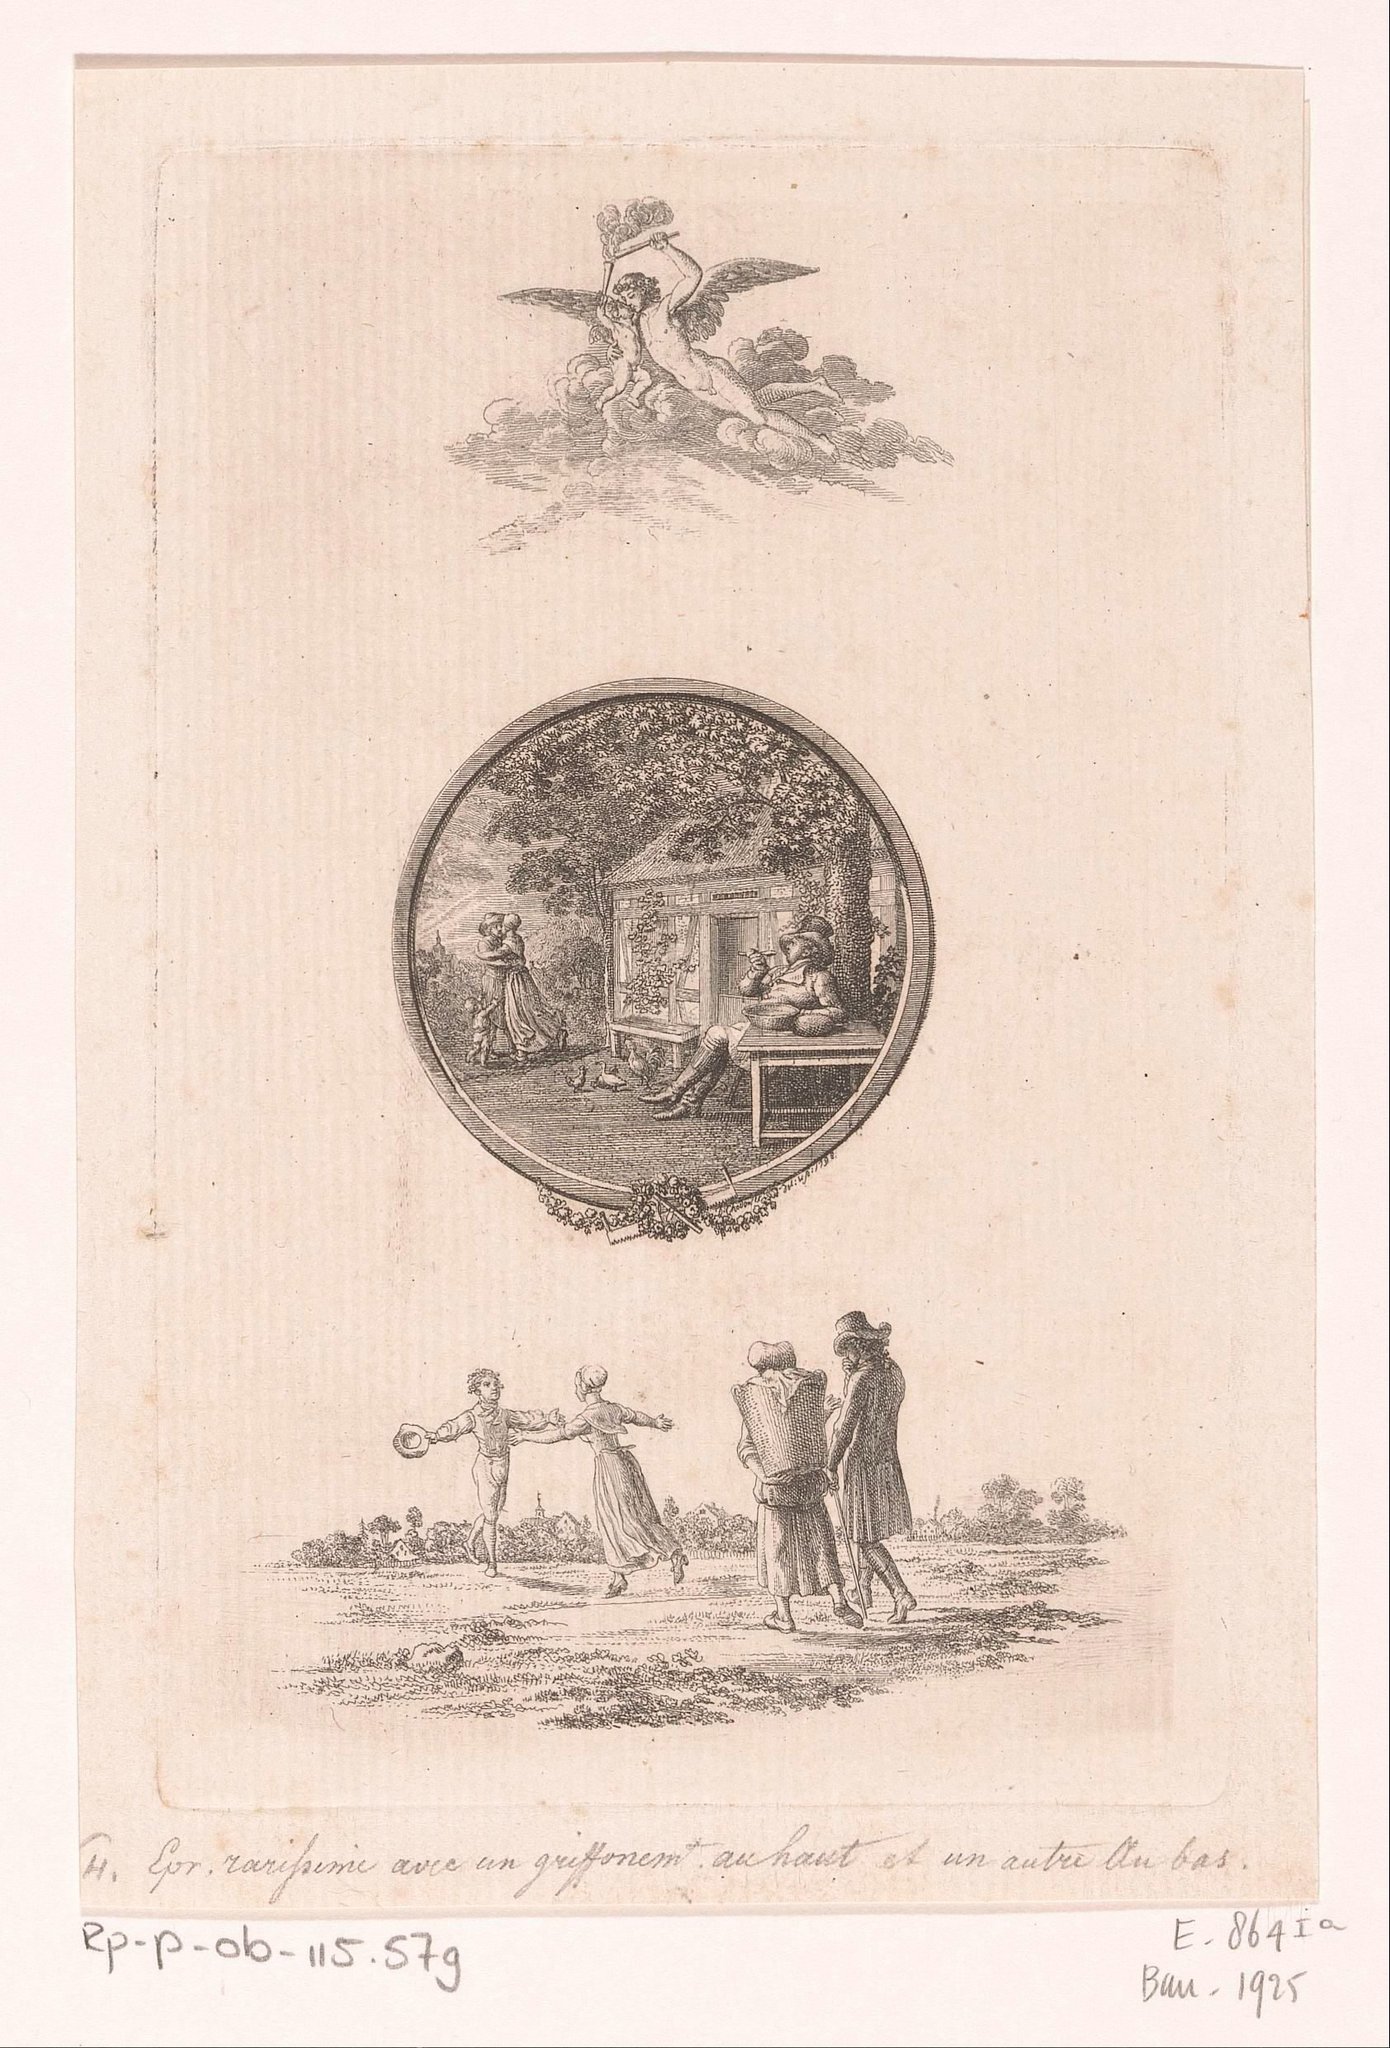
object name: print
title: Omhelzing bij thuiskomst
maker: daniel nikolaus chodowiecki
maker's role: draughtsman, print maker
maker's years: 1726-1801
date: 1798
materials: paper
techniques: etching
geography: berlin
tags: being welcomed ~ travelling, cottage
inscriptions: collector's mark: Lugt 2228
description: Latere staat gebruikt voor: Becker, Wilhelm Gottlieb. Darstellungen von W. G. Becker. 2 dln. Leipzig: Voss und Comp., 1798, dl. 2.